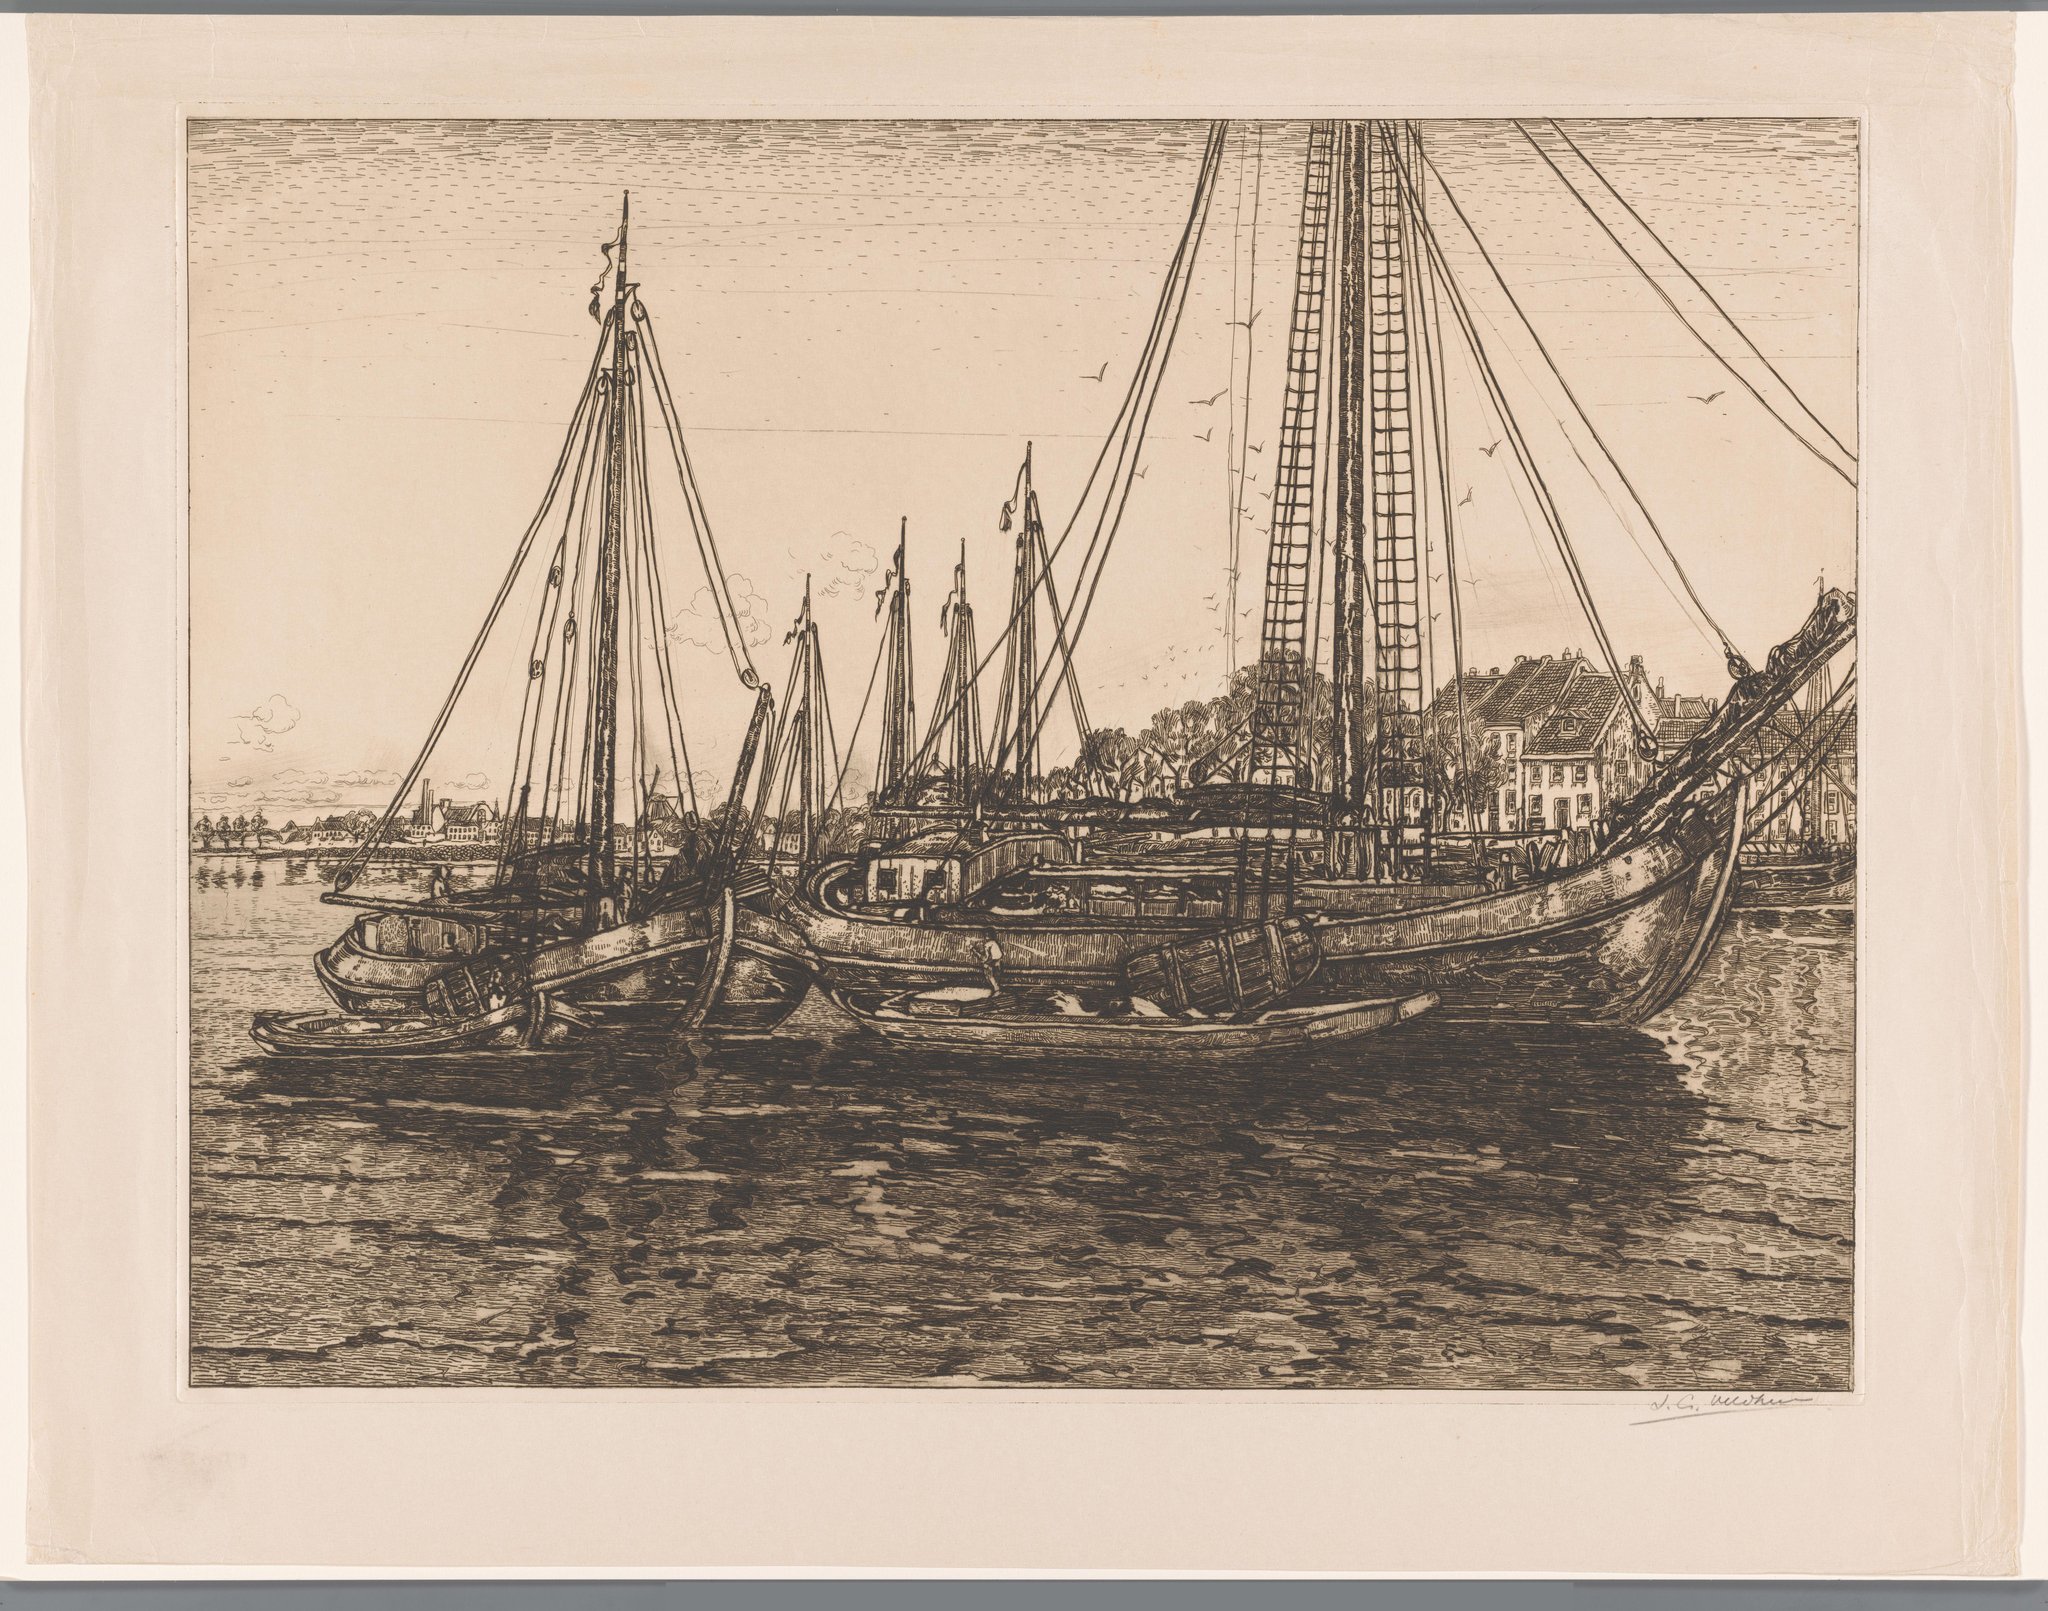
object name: print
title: Schepen op de Zaan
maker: jacobus gerardus veldheer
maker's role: draughtsman, print maker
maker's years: 1866-1954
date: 1876-1913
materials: paper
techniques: drypoint, etching, intaglio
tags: sailing-ship, sailing-boat, village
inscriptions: collector's mark: Lugt 2233